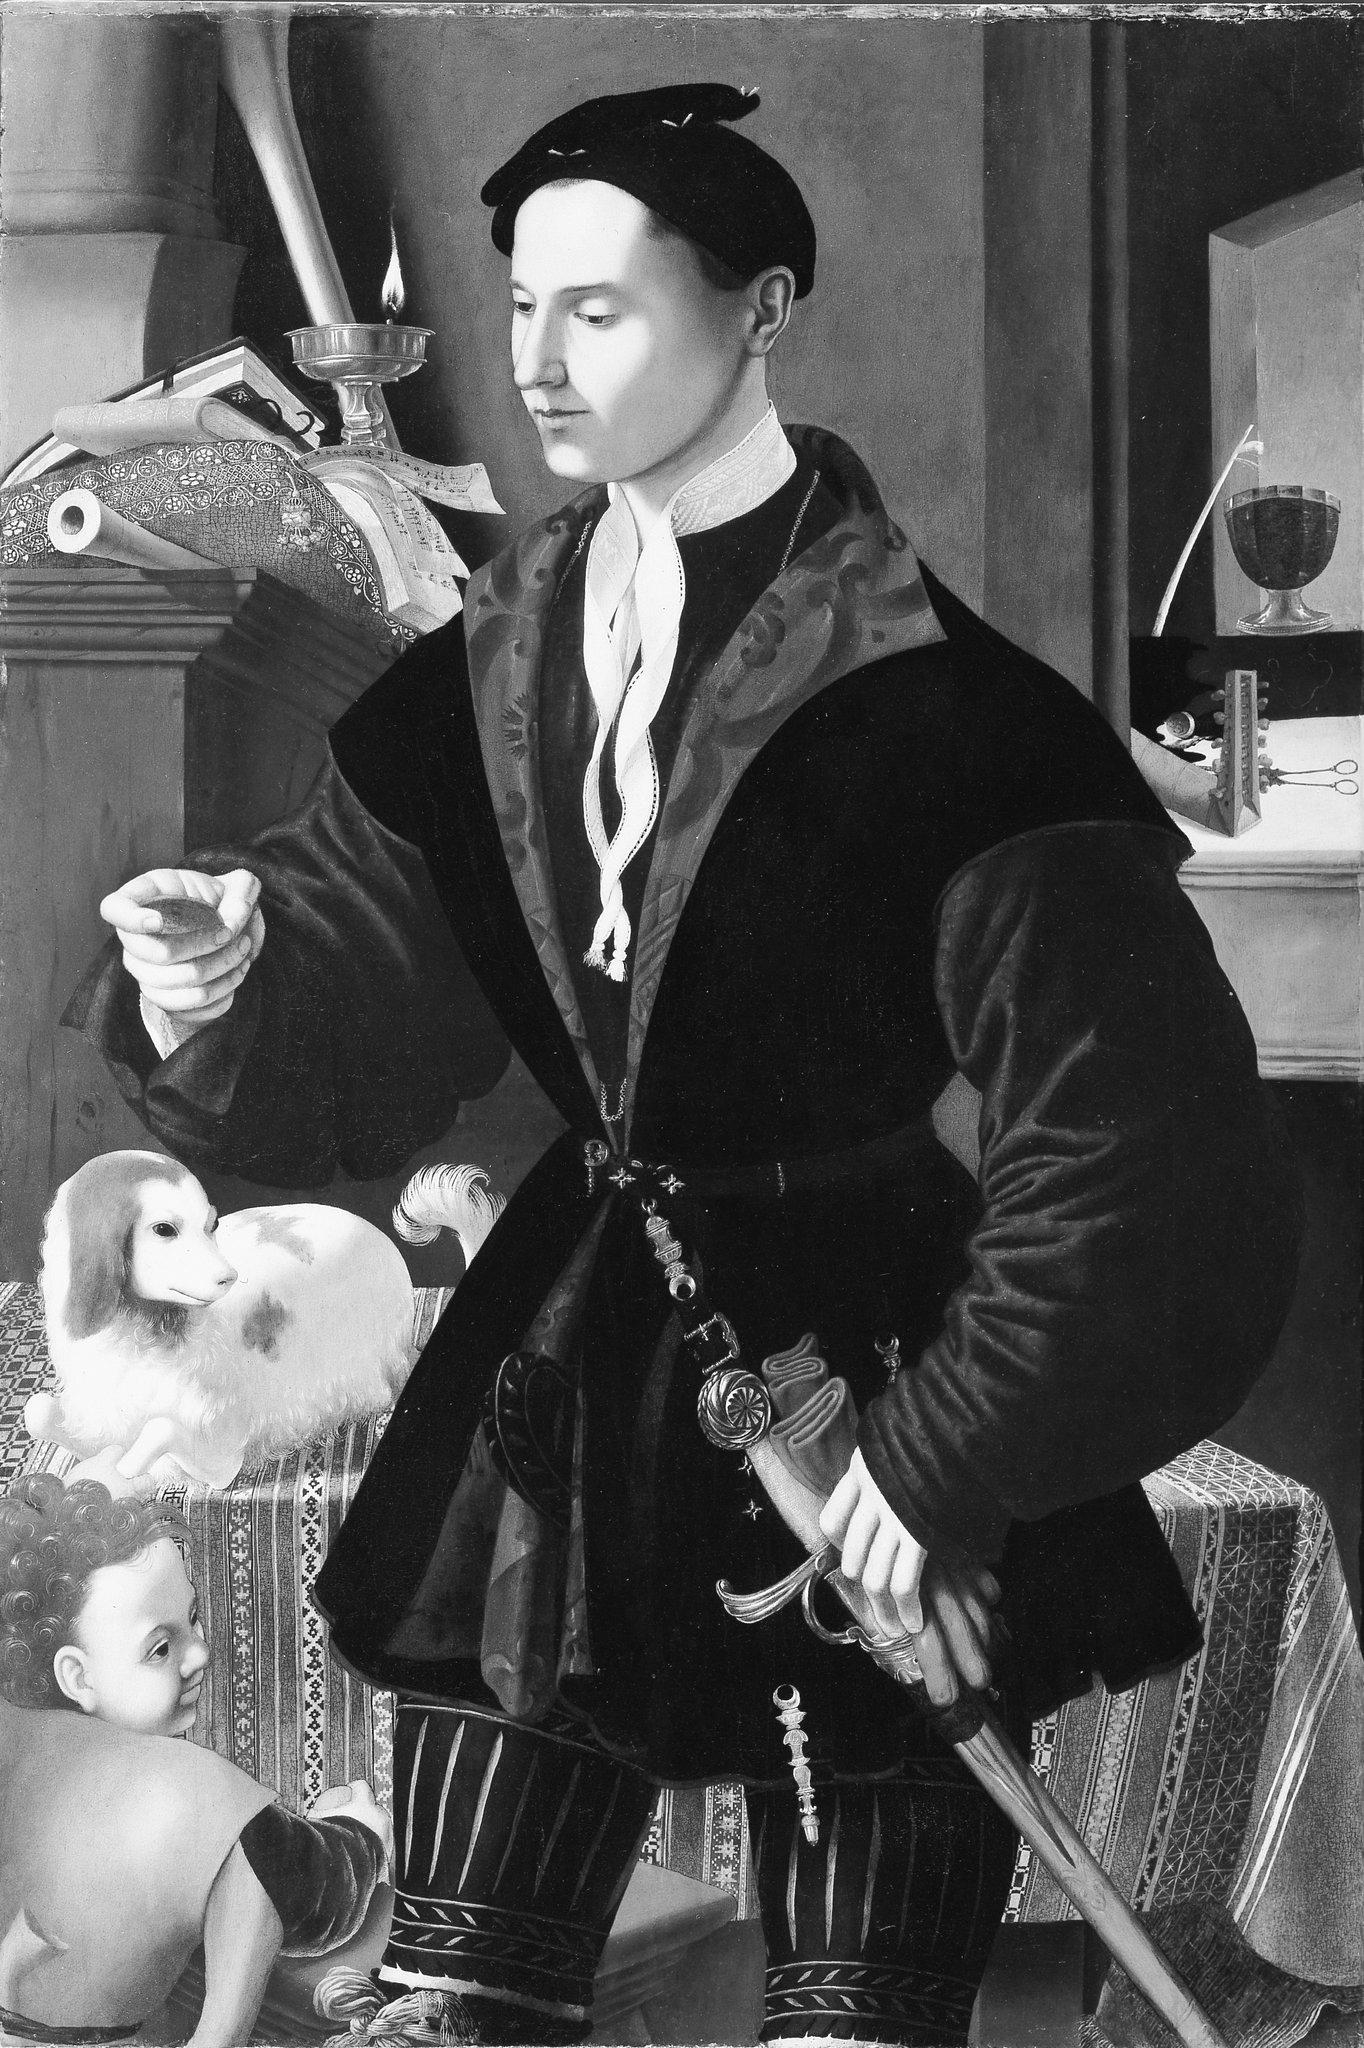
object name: painting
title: Portrait of a Young Man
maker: bernardino detti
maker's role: artist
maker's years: 1498-1572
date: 1524-1578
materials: oil, wood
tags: swords,men,portraits,dogs